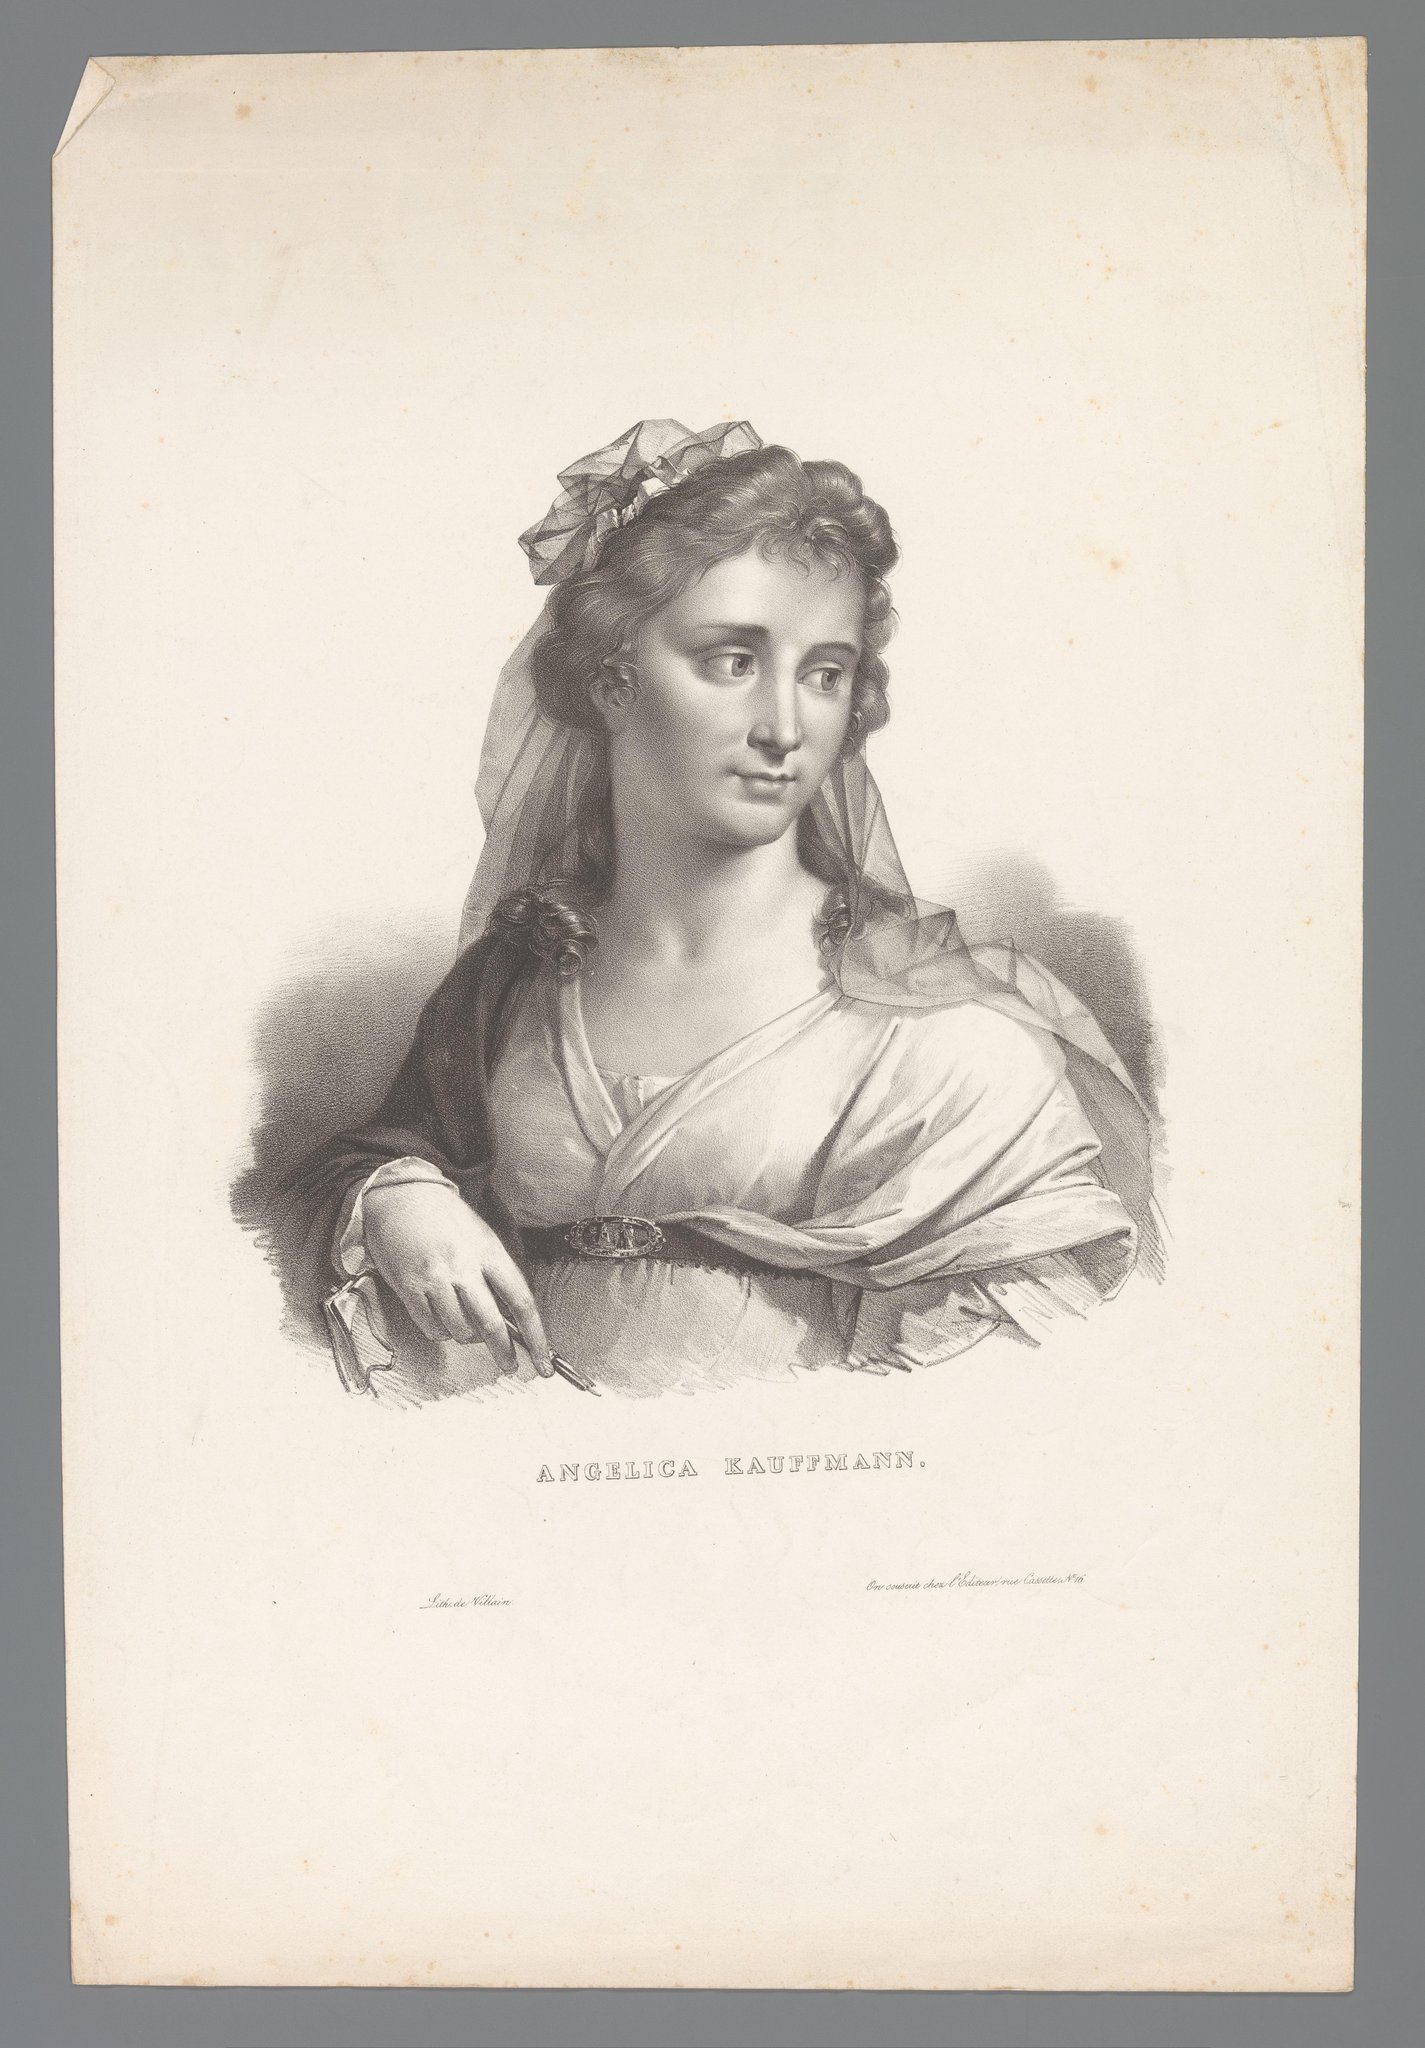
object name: print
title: Angelica Kauffmann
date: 1818-1852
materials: paper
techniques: lithograph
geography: paris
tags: rome, print maker, draughtsman, angelica kauffmann, historical persons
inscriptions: collector's mark: Lugt 2228